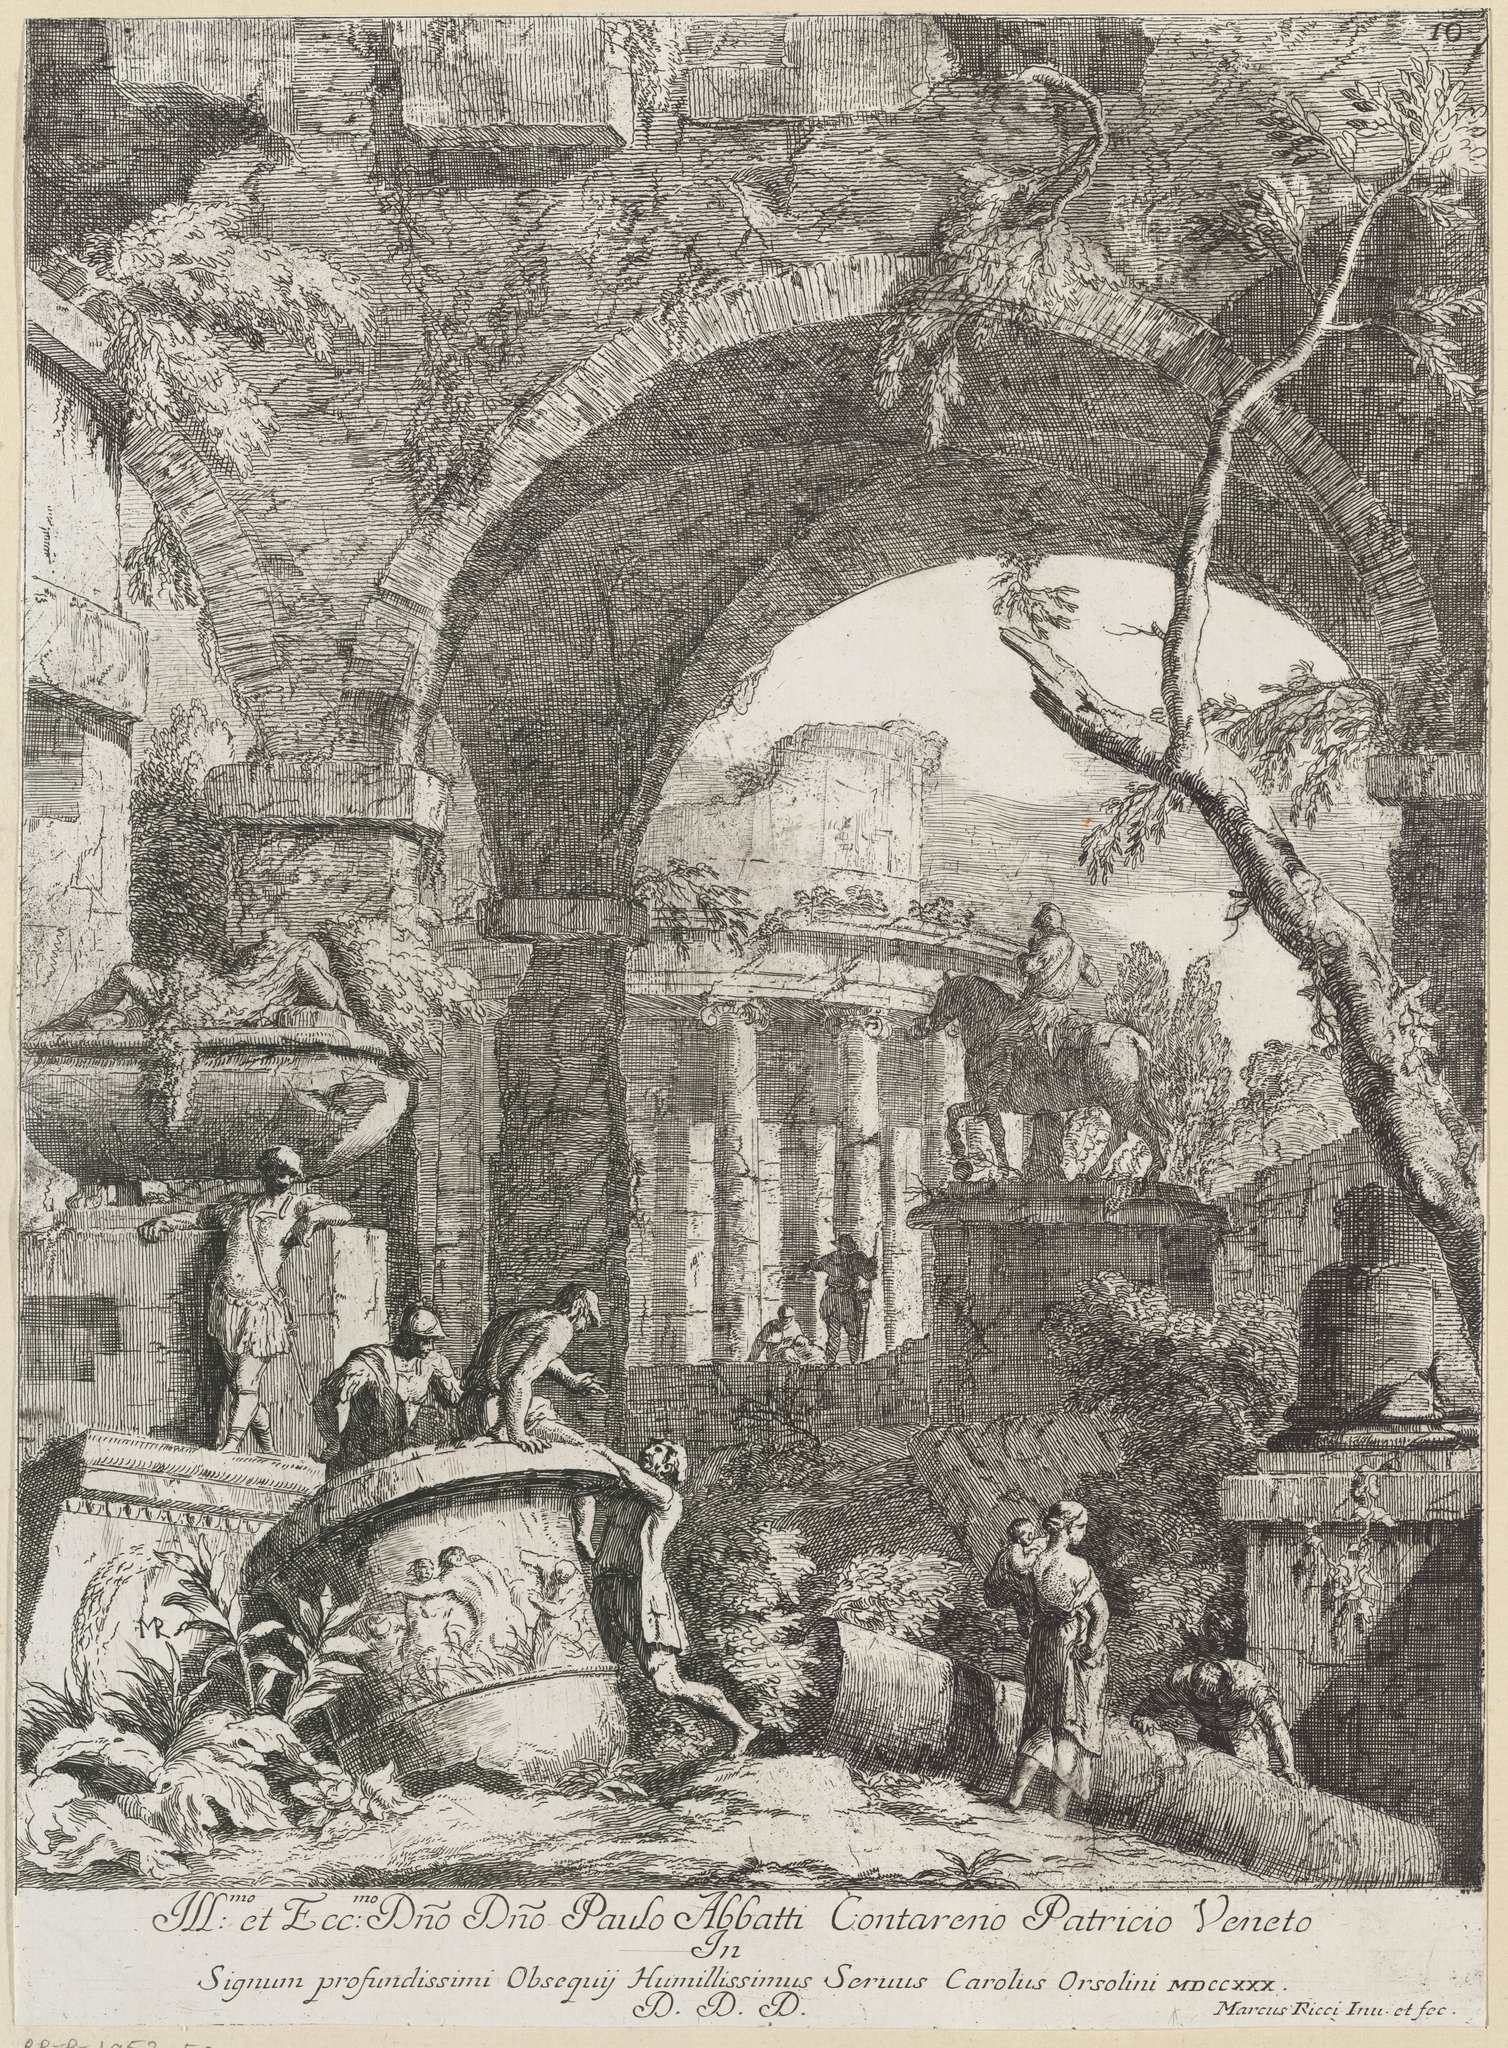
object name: print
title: Landschap met ruïnes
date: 1730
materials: paper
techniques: etching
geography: italy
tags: ruin of a building ~ architecture, piece of sculpture, reproduction of a piece of sculpture, equestrian statue, landscape with ruins - ii - ideal landscapes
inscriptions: collector's mark: Lugt 2228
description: Landschap met ruïnes van een Klassieke gebouwen, waaronder een ronde tempel. Op de voorgrond figuren op en naast een omgevallen vaas. Achter een boog een ruiterstandbeeld. Opdracht in ondermarge.